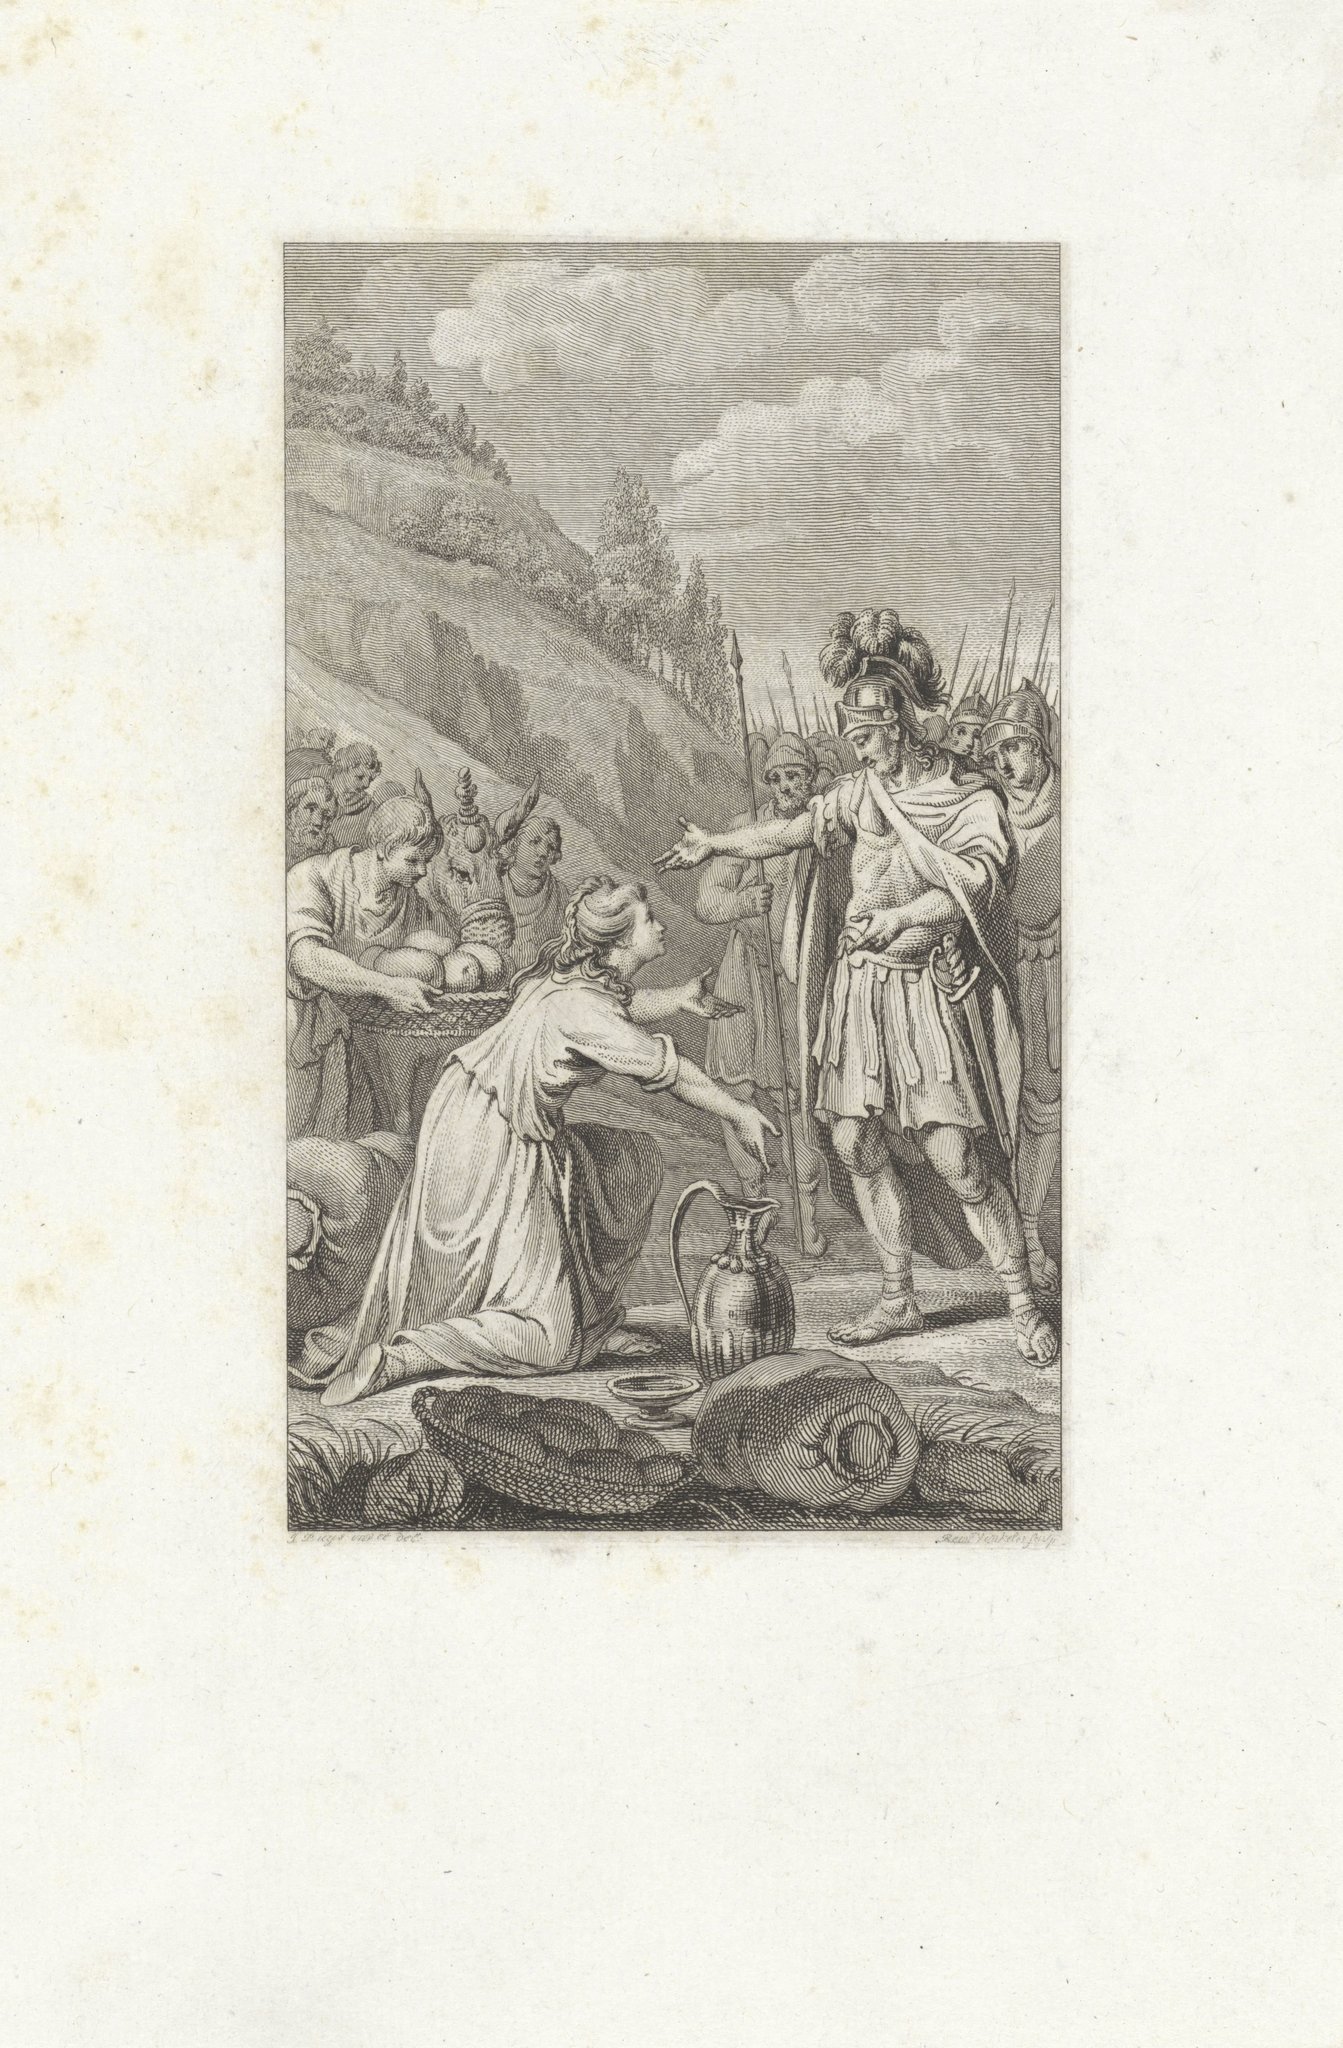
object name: print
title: Ontmoeting van David en Abigaïl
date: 1797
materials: paper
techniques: engraving, etching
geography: amsterdam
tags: meeting of david and abigail, who kneels before him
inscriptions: collector's mark: Lugt 240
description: Wanneer een gierige boer weigert David en zijn manschappen te helpen, dreigen ze hem te straffen. Abigaïl, de vrouw van de boer, knielt voor David en biedt hem en zijn soldaten eten en drinken aan. Daarmee stemde ze David tevreden.